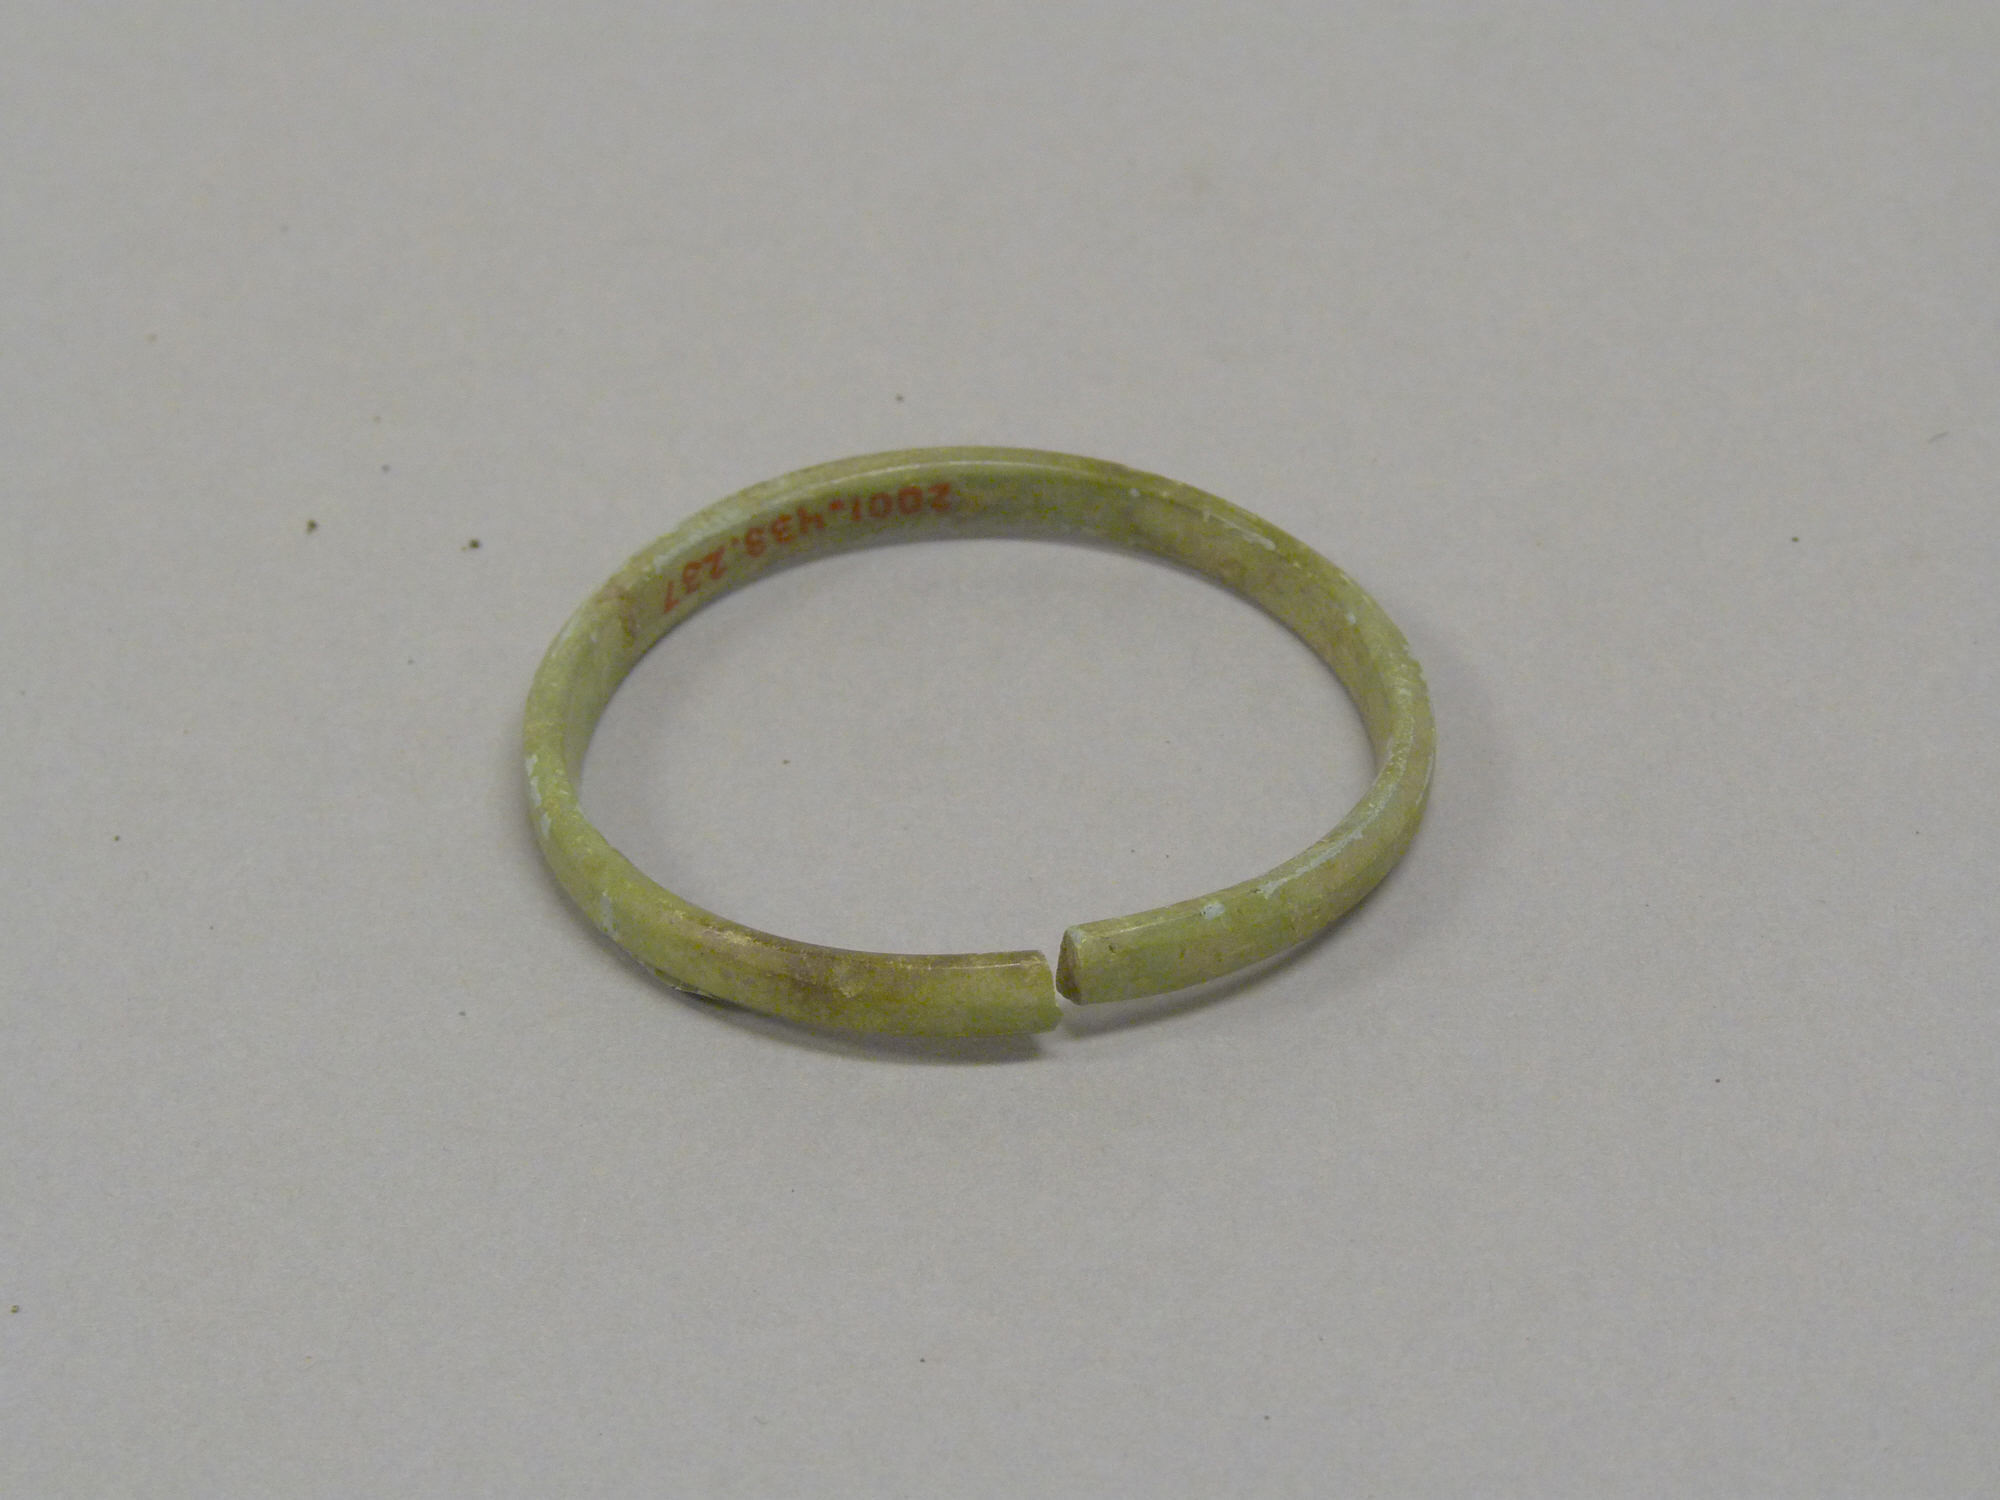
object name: bangle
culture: thai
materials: bronze